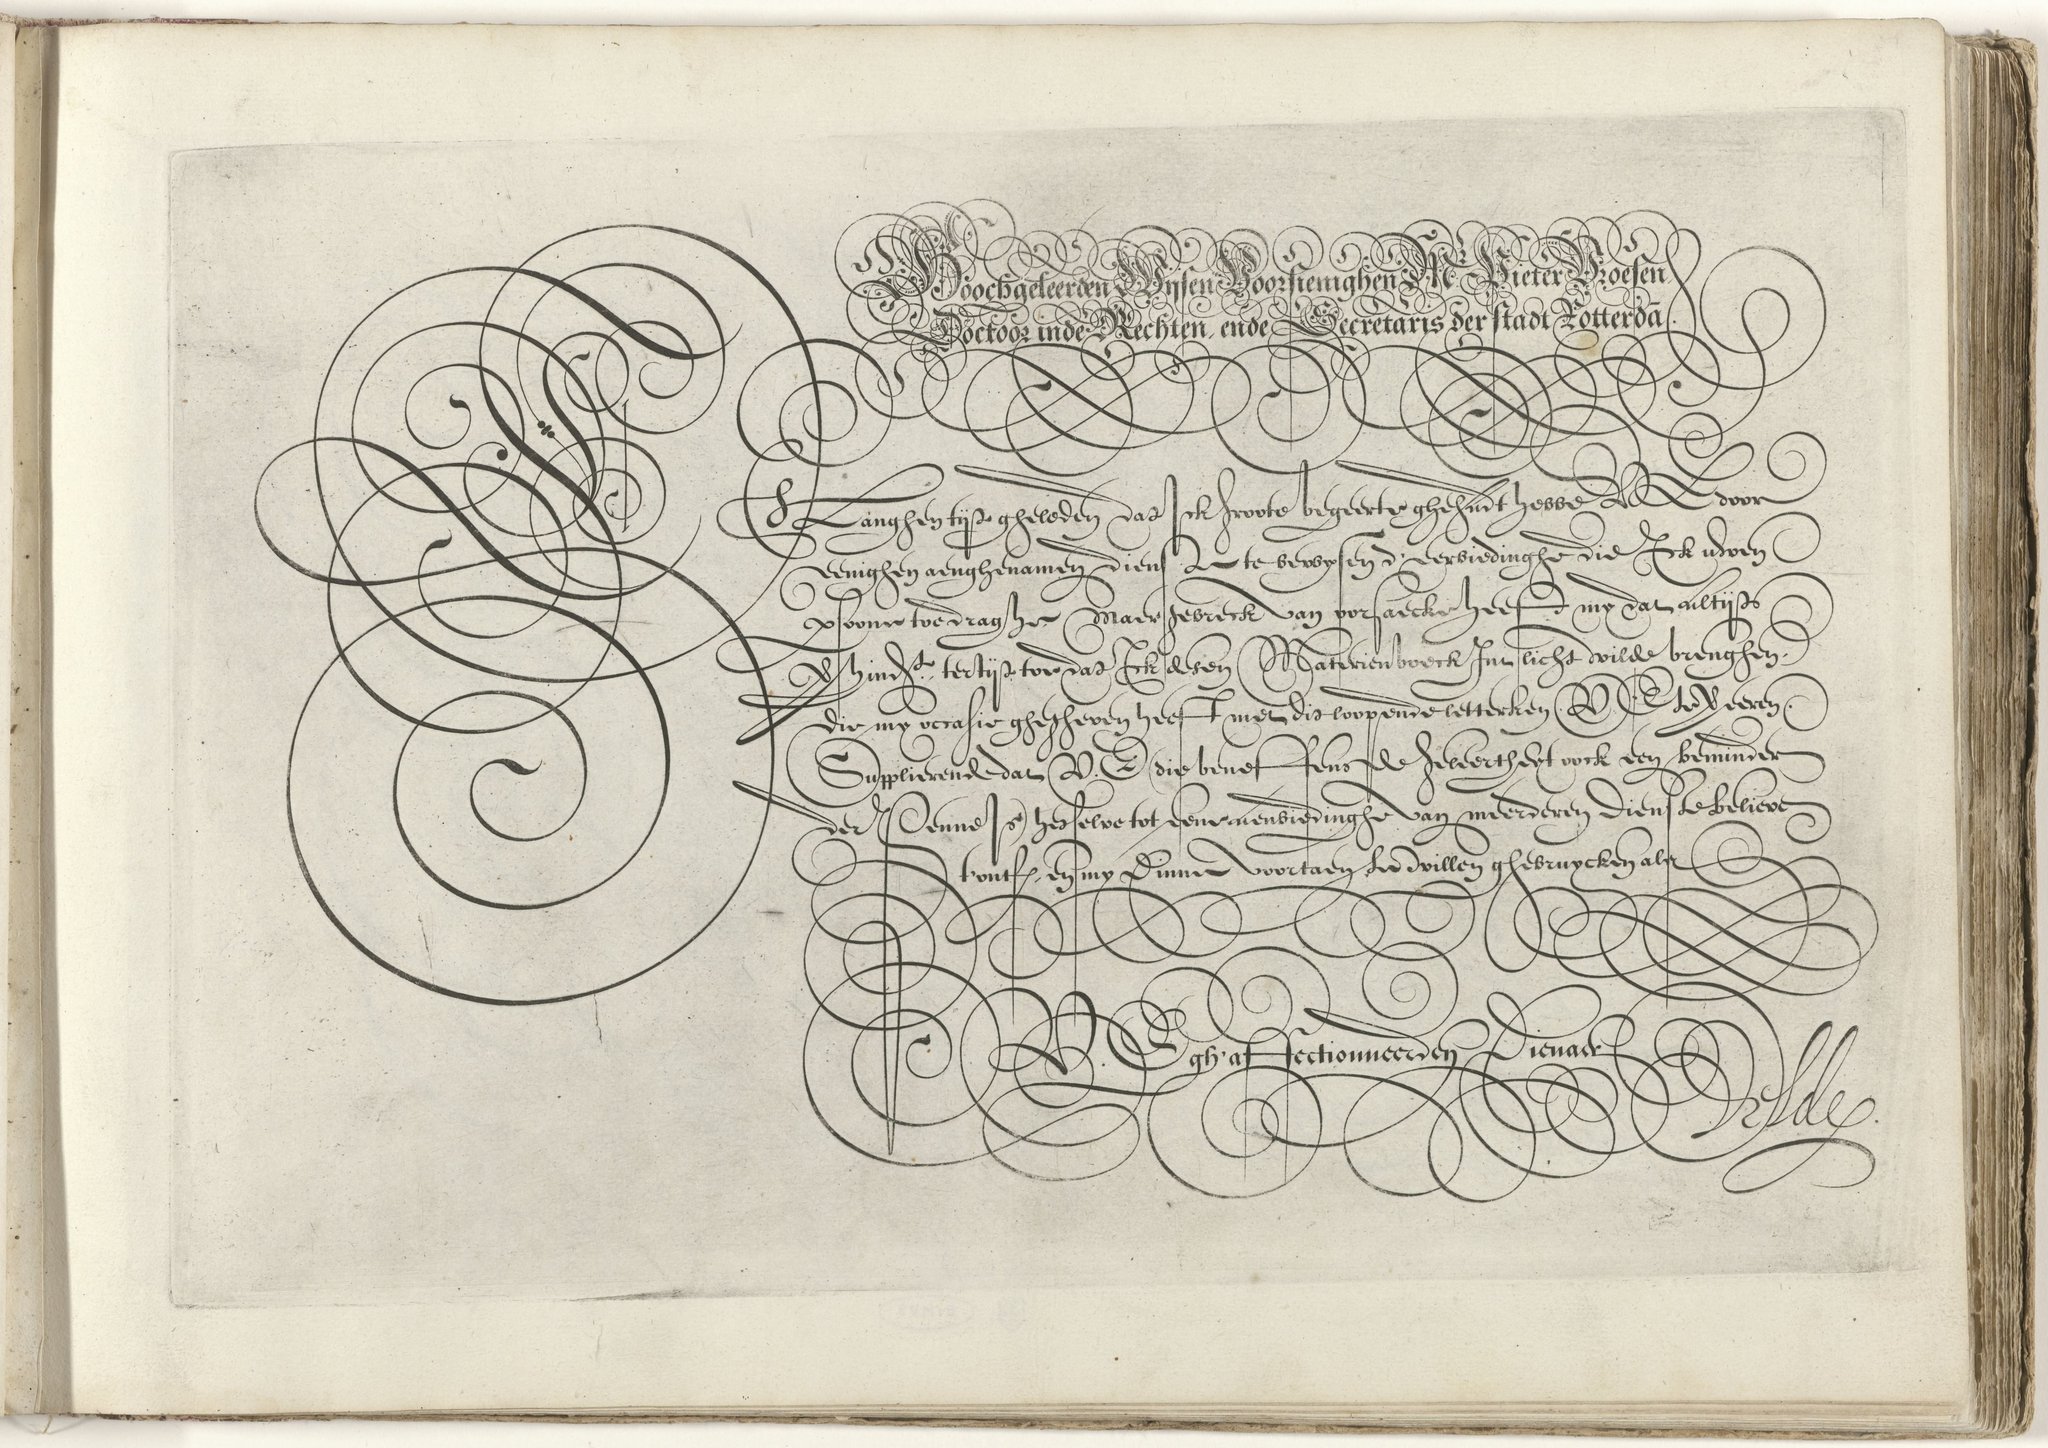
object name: album leaf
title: Spieghel der schrijfkonste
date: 1605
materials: paper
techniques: engraving, intaglio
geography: haarlem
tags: calligraphy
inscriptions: collector's mark: Lugt 2760, collector's mark: Lugt 2228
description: Schrijfvoorbeeld met de aanhef: Hoochgeleerden Wijsen Voorsienighen Mr Pieter Vroesen, Doctoor inde Rechten ende Secretaris der stadt Rotterda(m). Daaronder in een andere letter een geornamenteerde initiaal en acht regels tekst in het Nederlands. De tekst is omlijst door krulwerk. De prent maakt deel uit van een album.